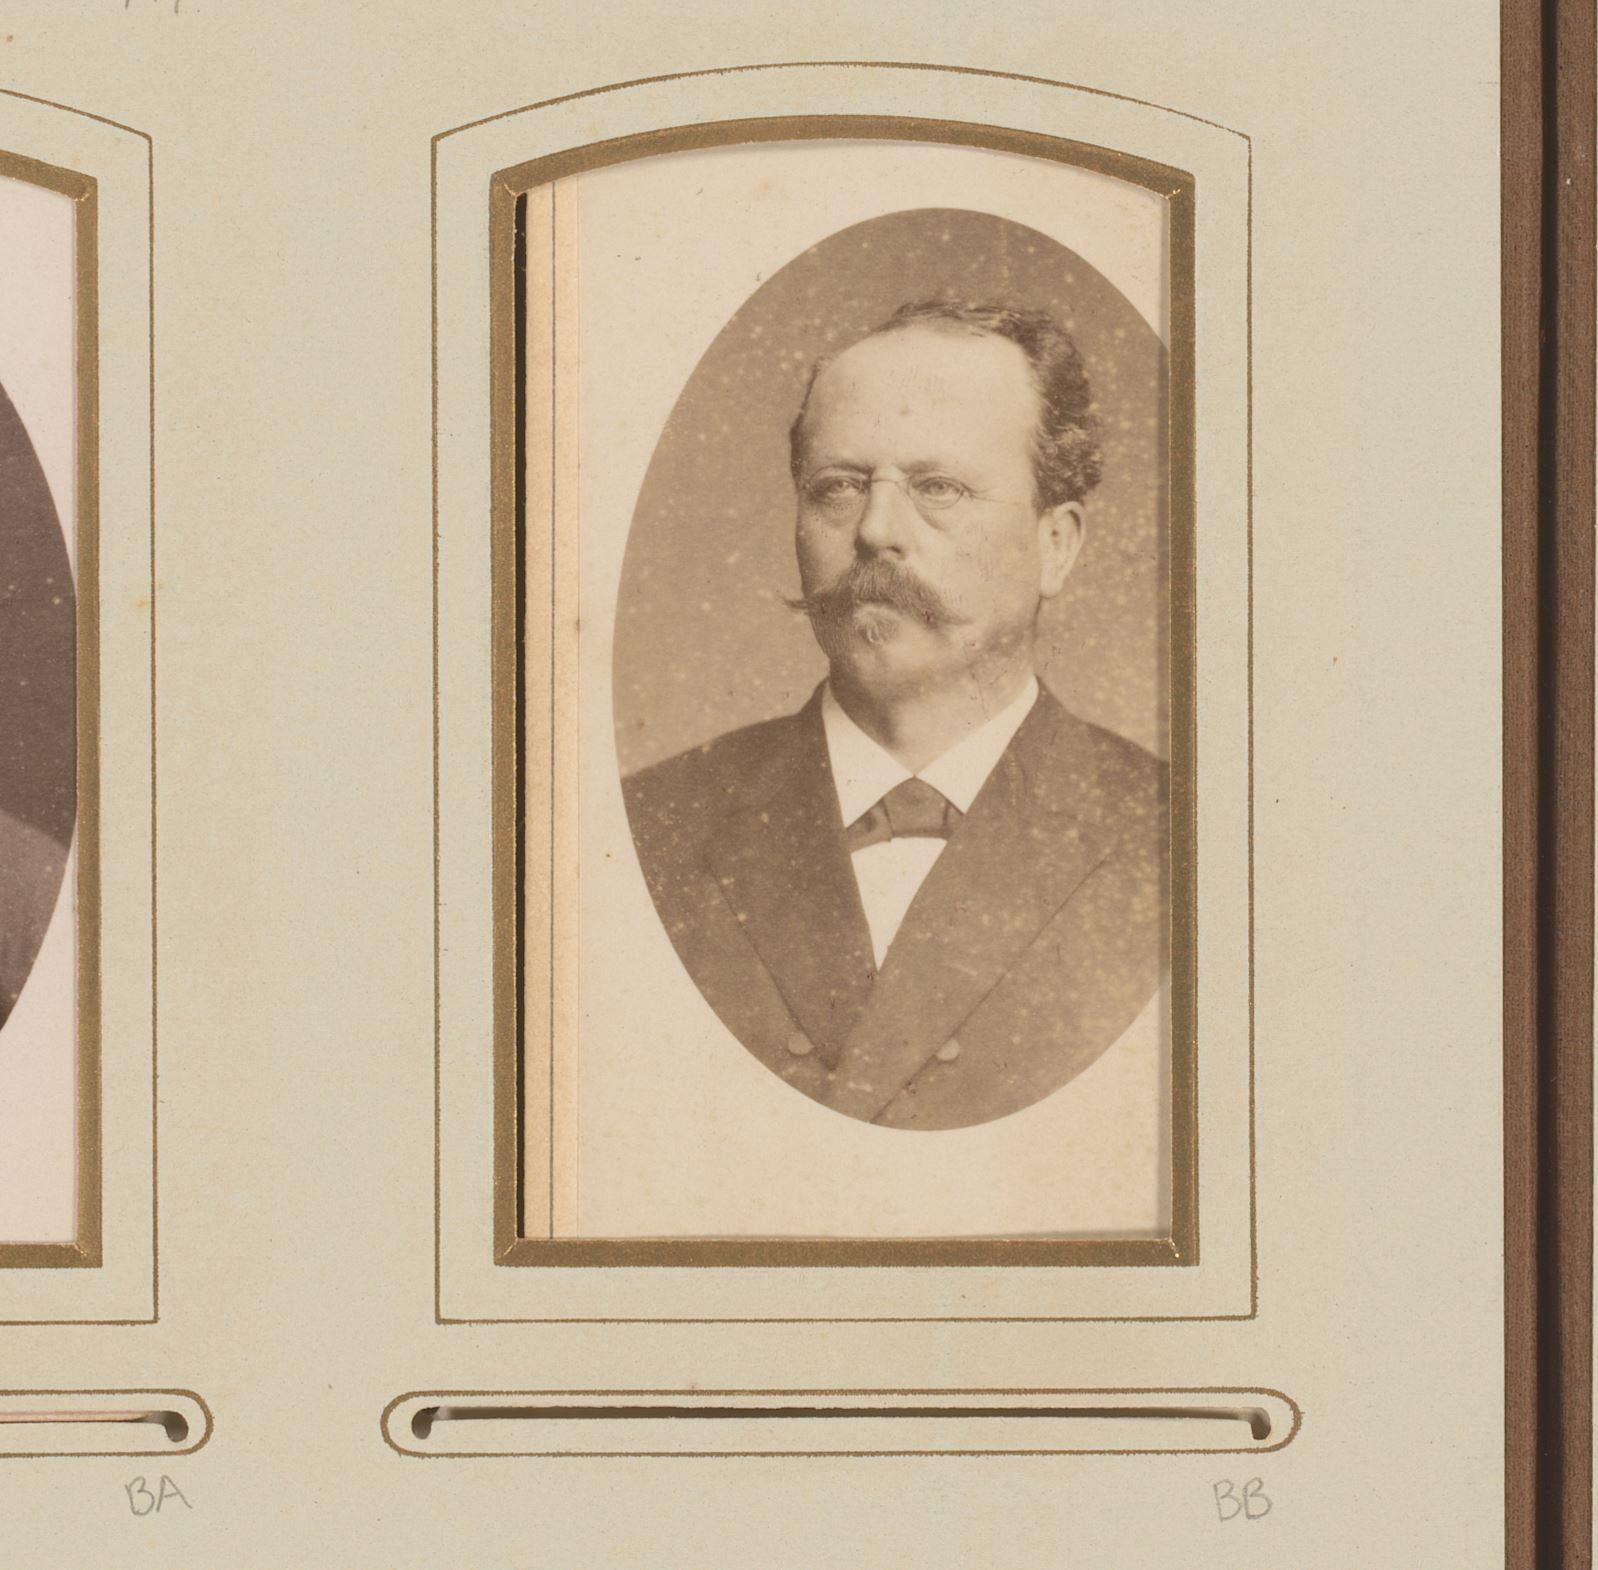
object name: album leaf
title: Portret van een man met snor en bril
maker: otto wunder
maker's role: fotograaf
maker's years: 1844-1921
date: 1885-1890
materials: cardboard, photographic support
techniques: albumen print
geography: hannover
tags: eyeglasses, spectacles, moustache, historical persons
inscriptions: inscription: ‘F. WUNDER SOHN/ PHOTOGRAPH. ANSTALT/ HANNOVER/ Ernst-Augustplatz 6/ gegenüber dem Bahn hofe/ 1885/ Platte wird für Vergrösserungen und Nachbestellungen aufbewahrt.’